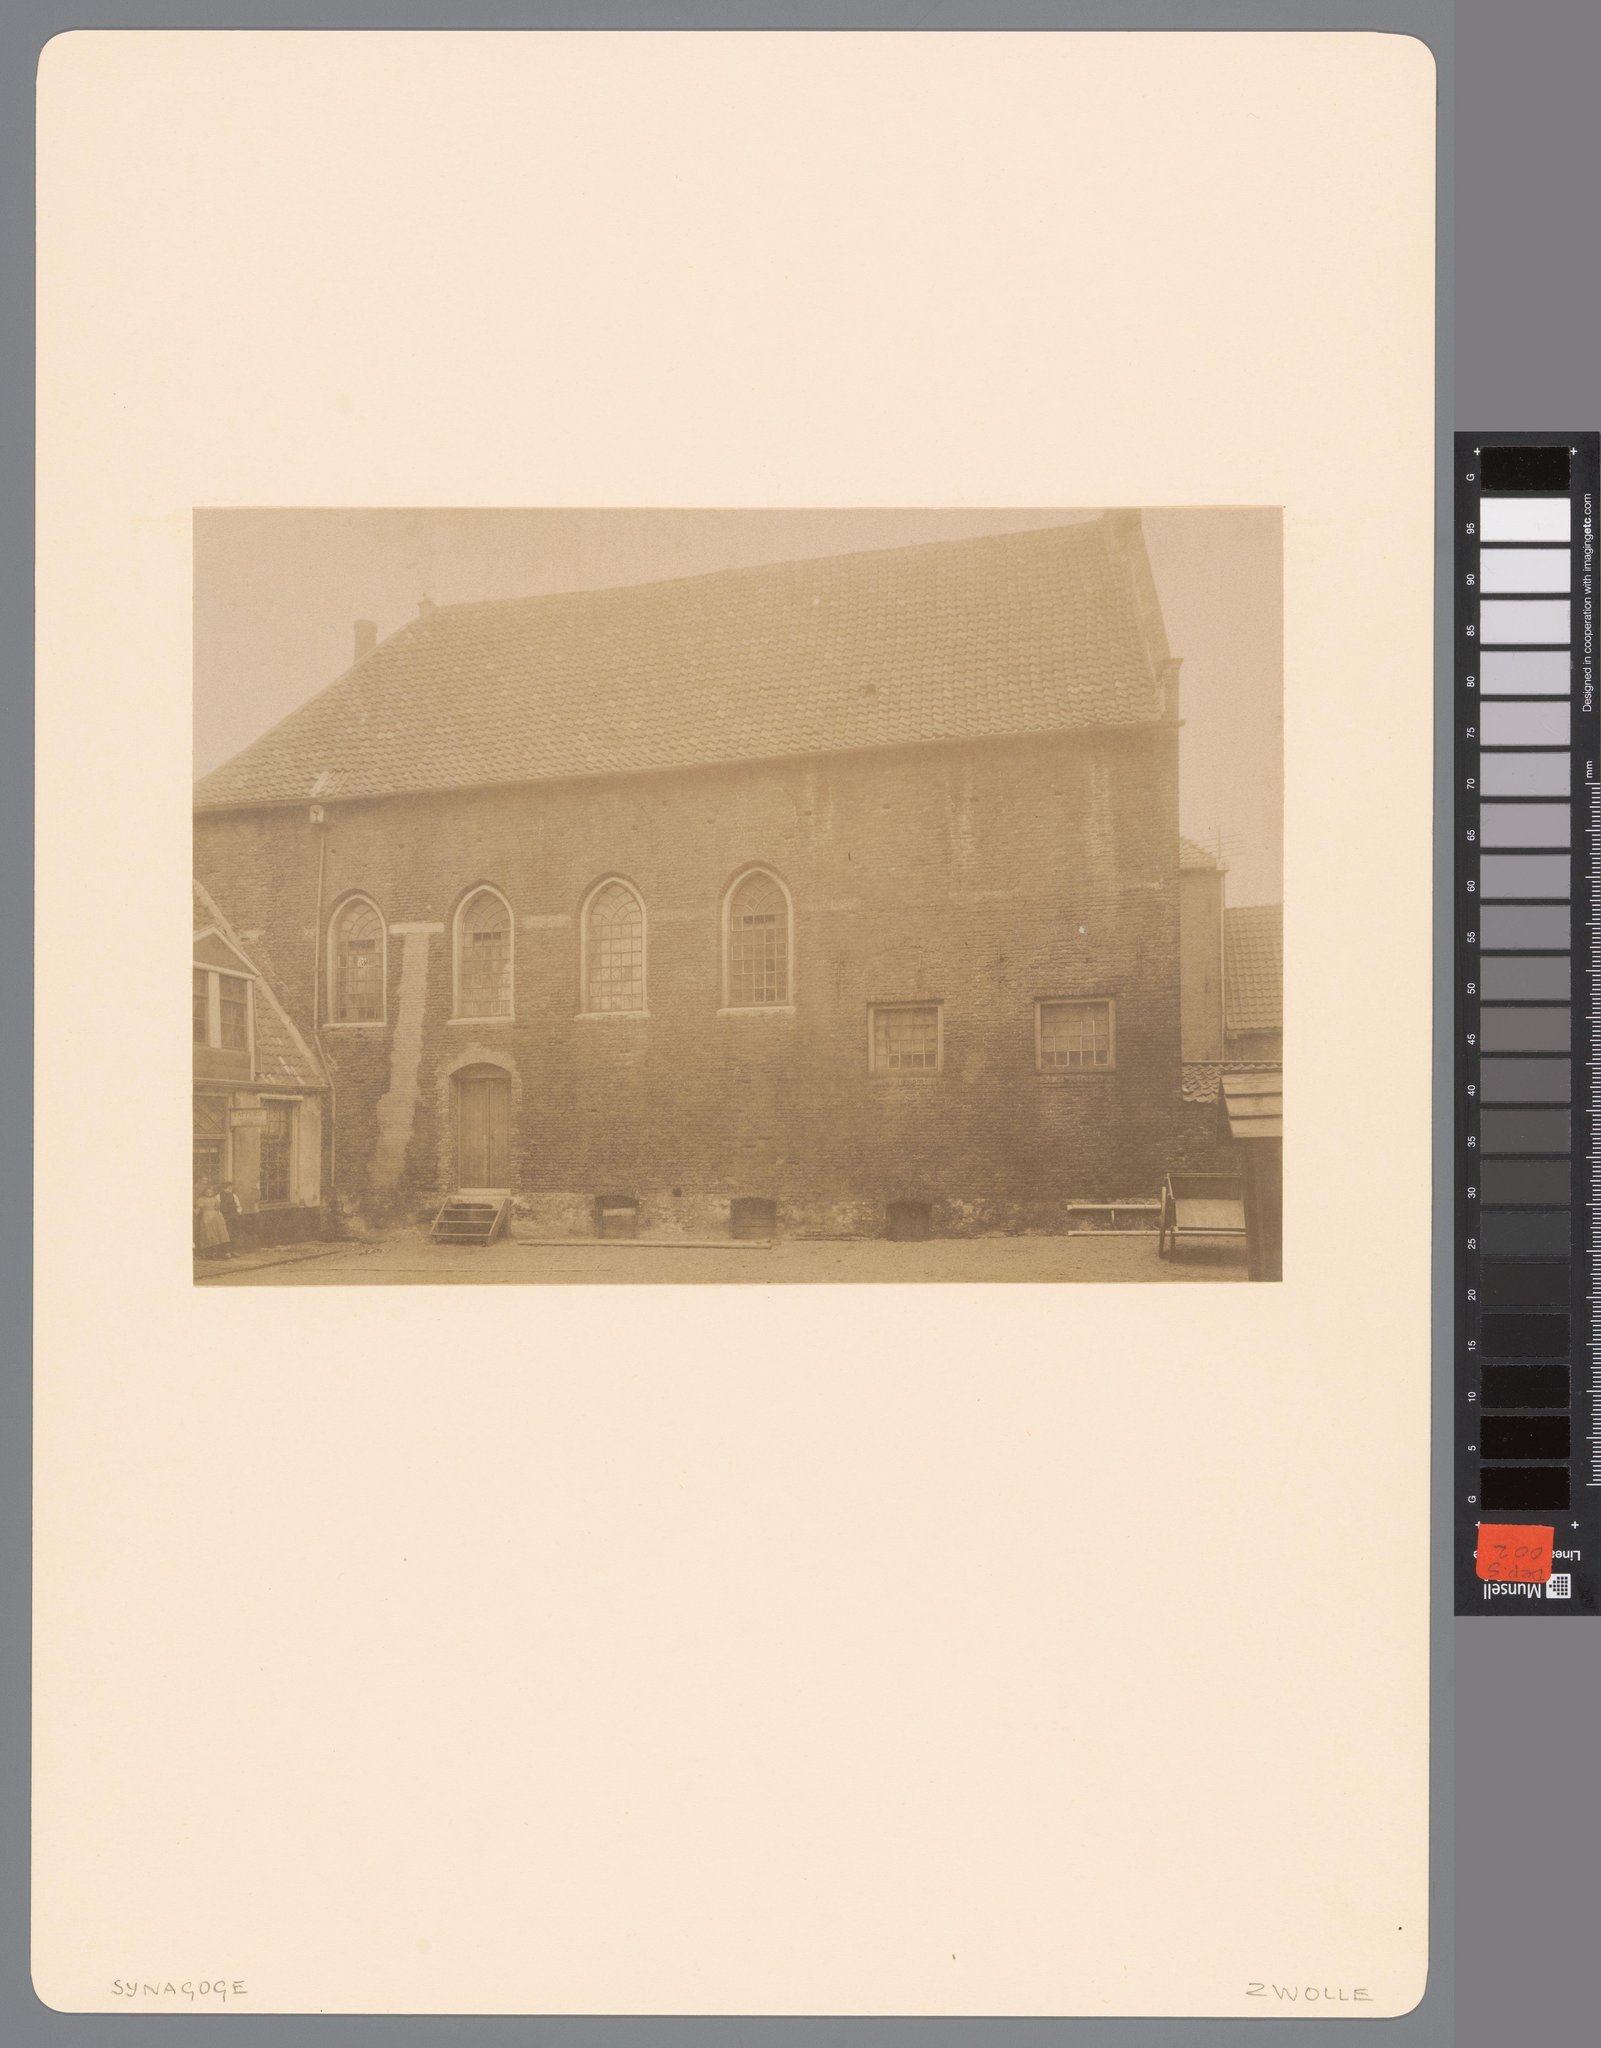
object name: photograph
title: Gezicht op de synagoge te Zwolle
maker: anoniem (monumentenzorg)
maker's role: fotograaf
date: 1899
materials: cardboard, photographic support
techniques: albumen print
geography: zwolle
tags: the synagogue (as building and place of worship ~ jewish religion)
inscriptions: annotation: ‘Zwolle synagoge maart 1899 (O.IJ. wordt afgebroke’, annotation: ‘Synagoge/ Zwolle’